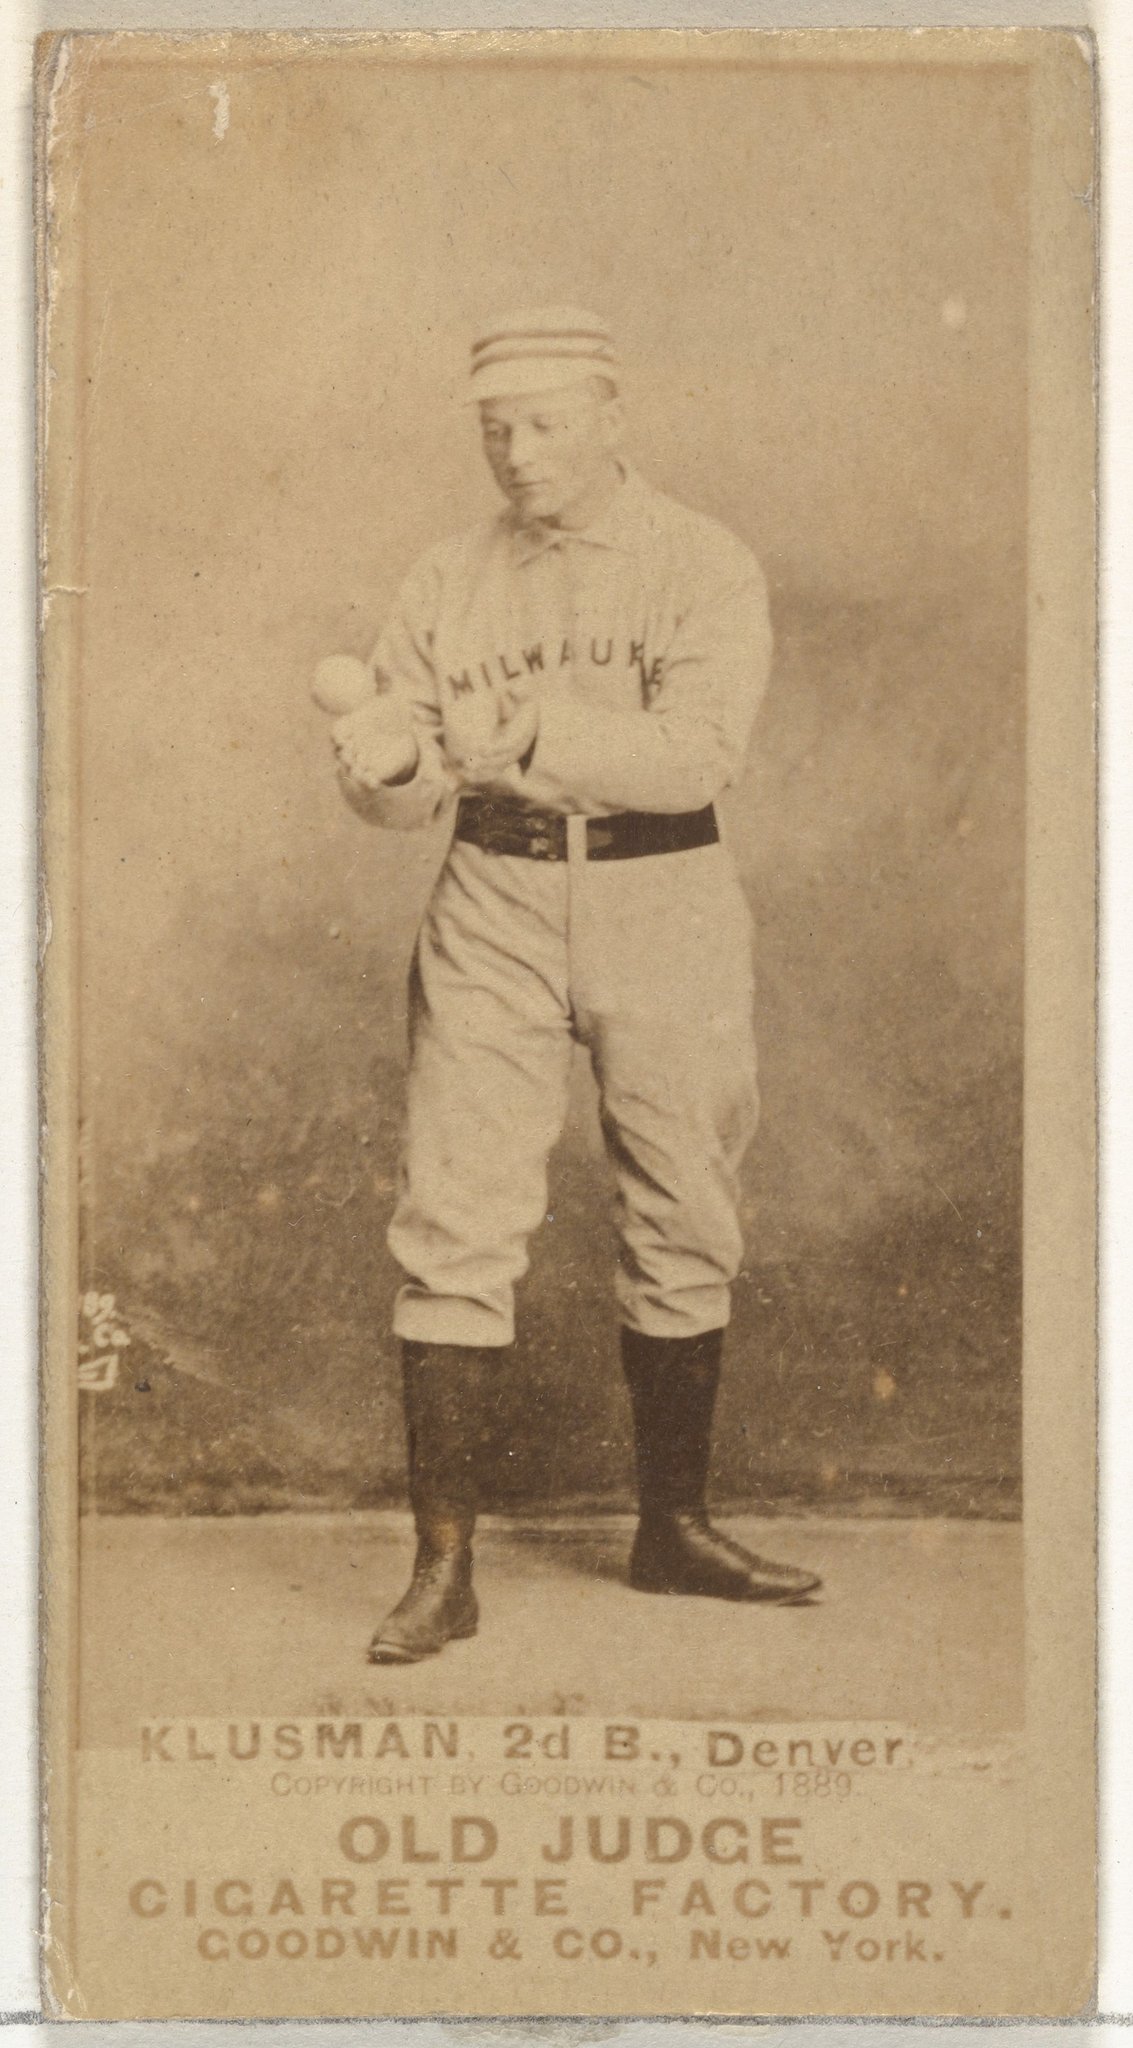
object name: baseball card, photograph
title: William F. "Billy" Klusman, 2nd Base, Denver, from the Old Judge series (N172) for Old Judge Cigarettes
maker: goodwin & company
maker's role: publisher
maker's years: 1850-1950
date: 1889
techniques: albumen silver print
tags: men,portraits,baseball,athletes